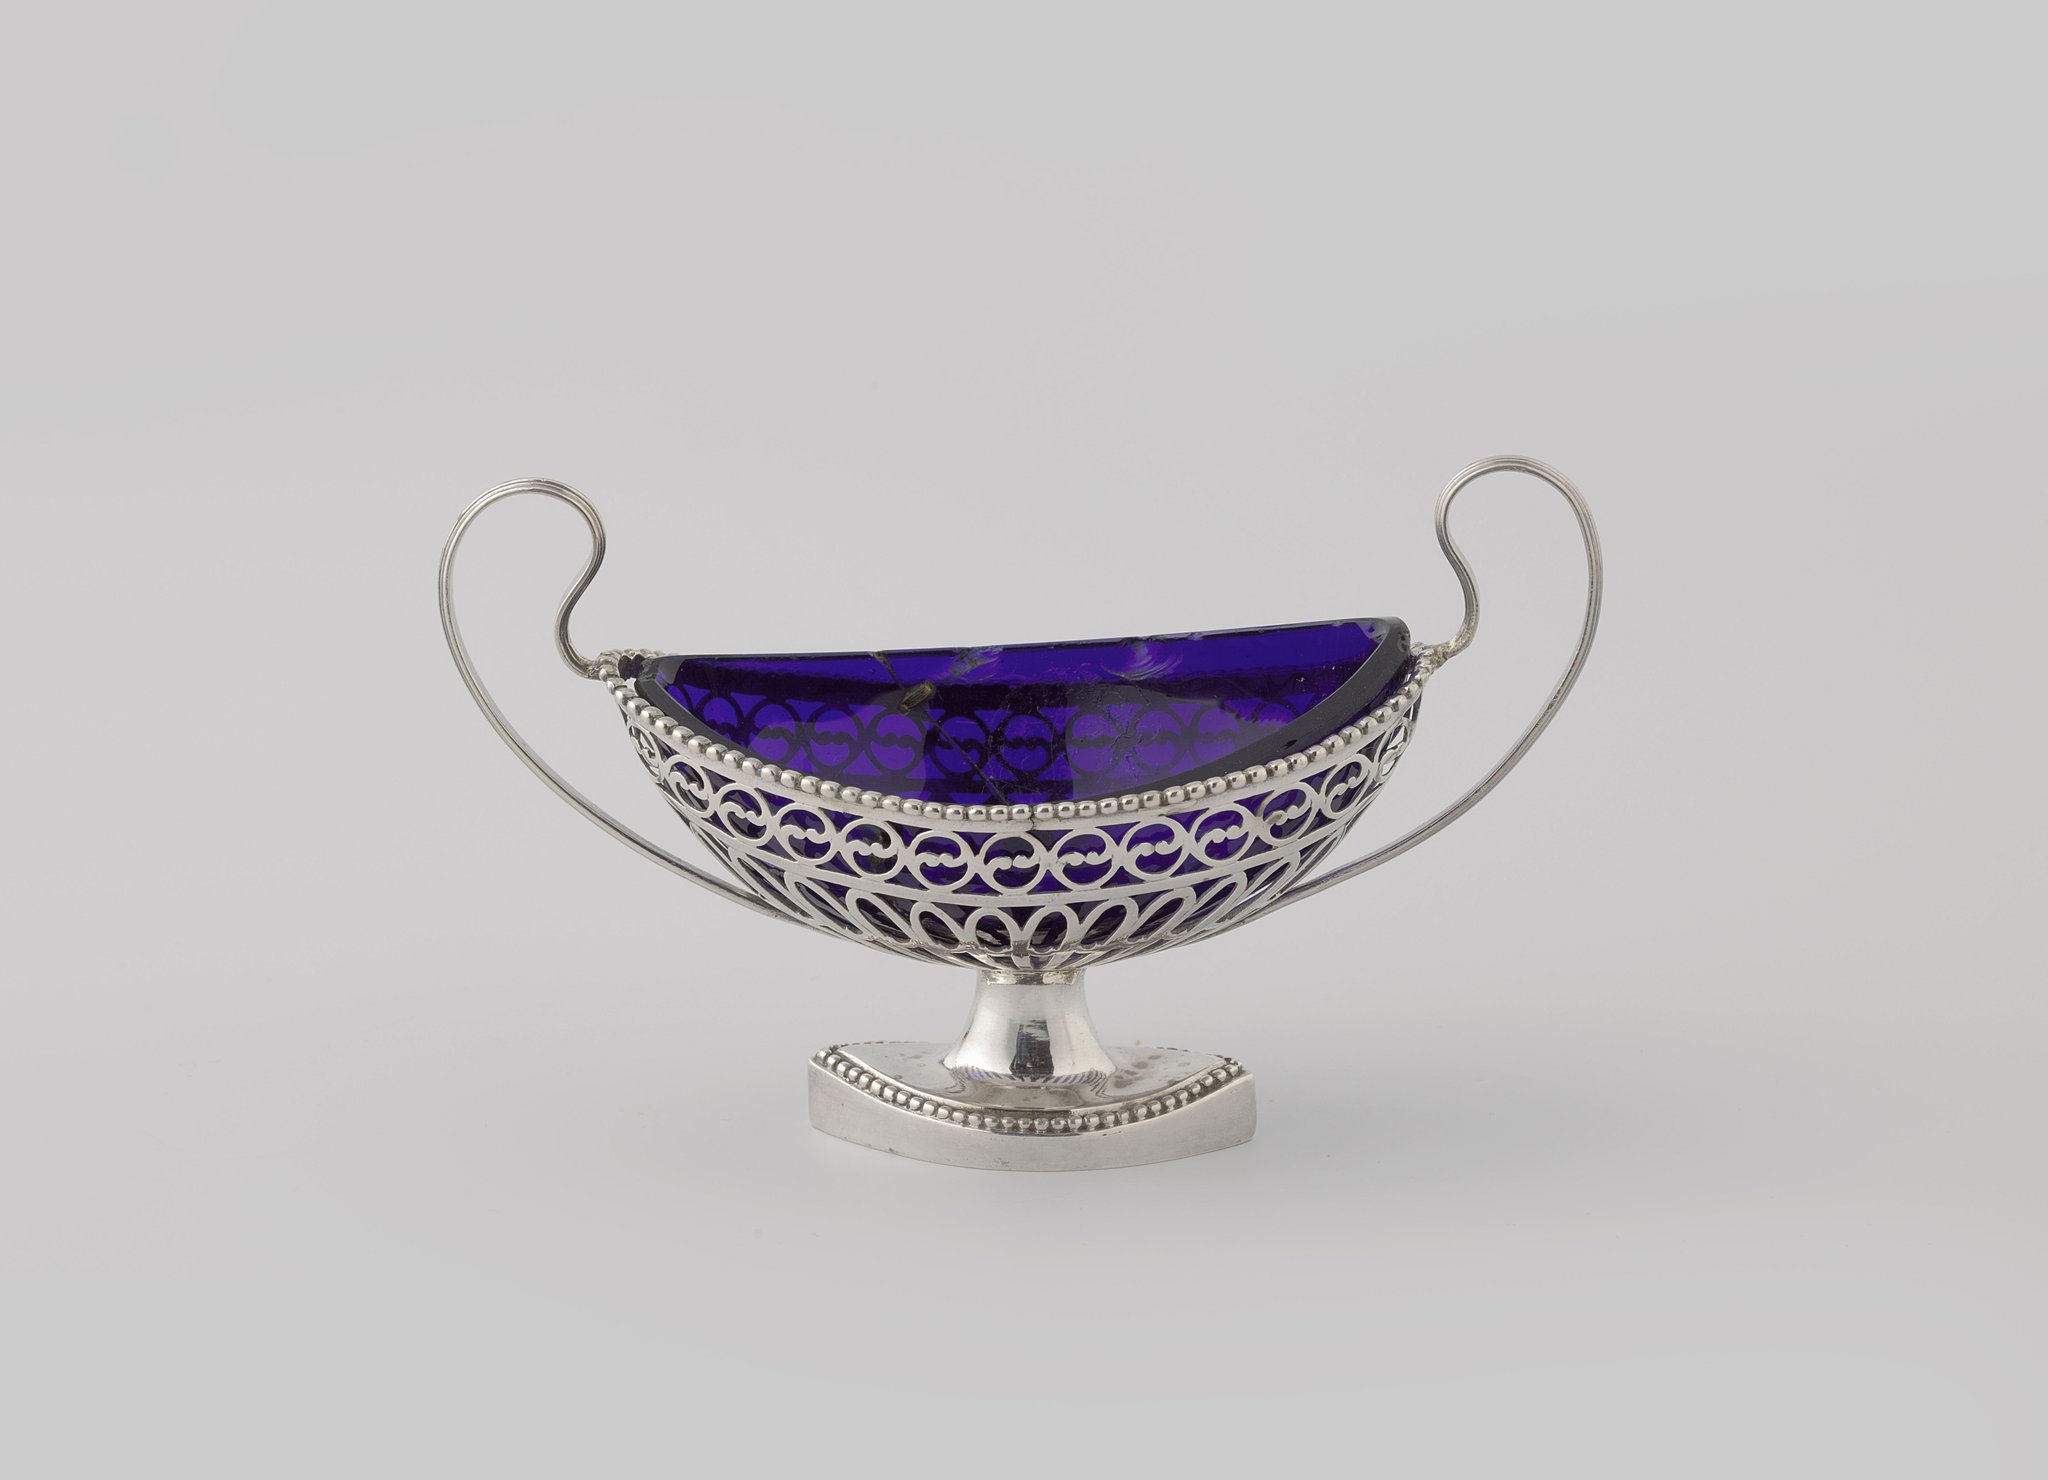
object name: salt condiment vessel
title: Binnenbak van zoutvat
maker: christiaan mensink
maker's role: silversmith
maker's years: 1770-1839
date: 1803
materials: glass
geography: amsterdam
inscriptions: date letter: ‘U’, maker's mark, alloy mark, town mark